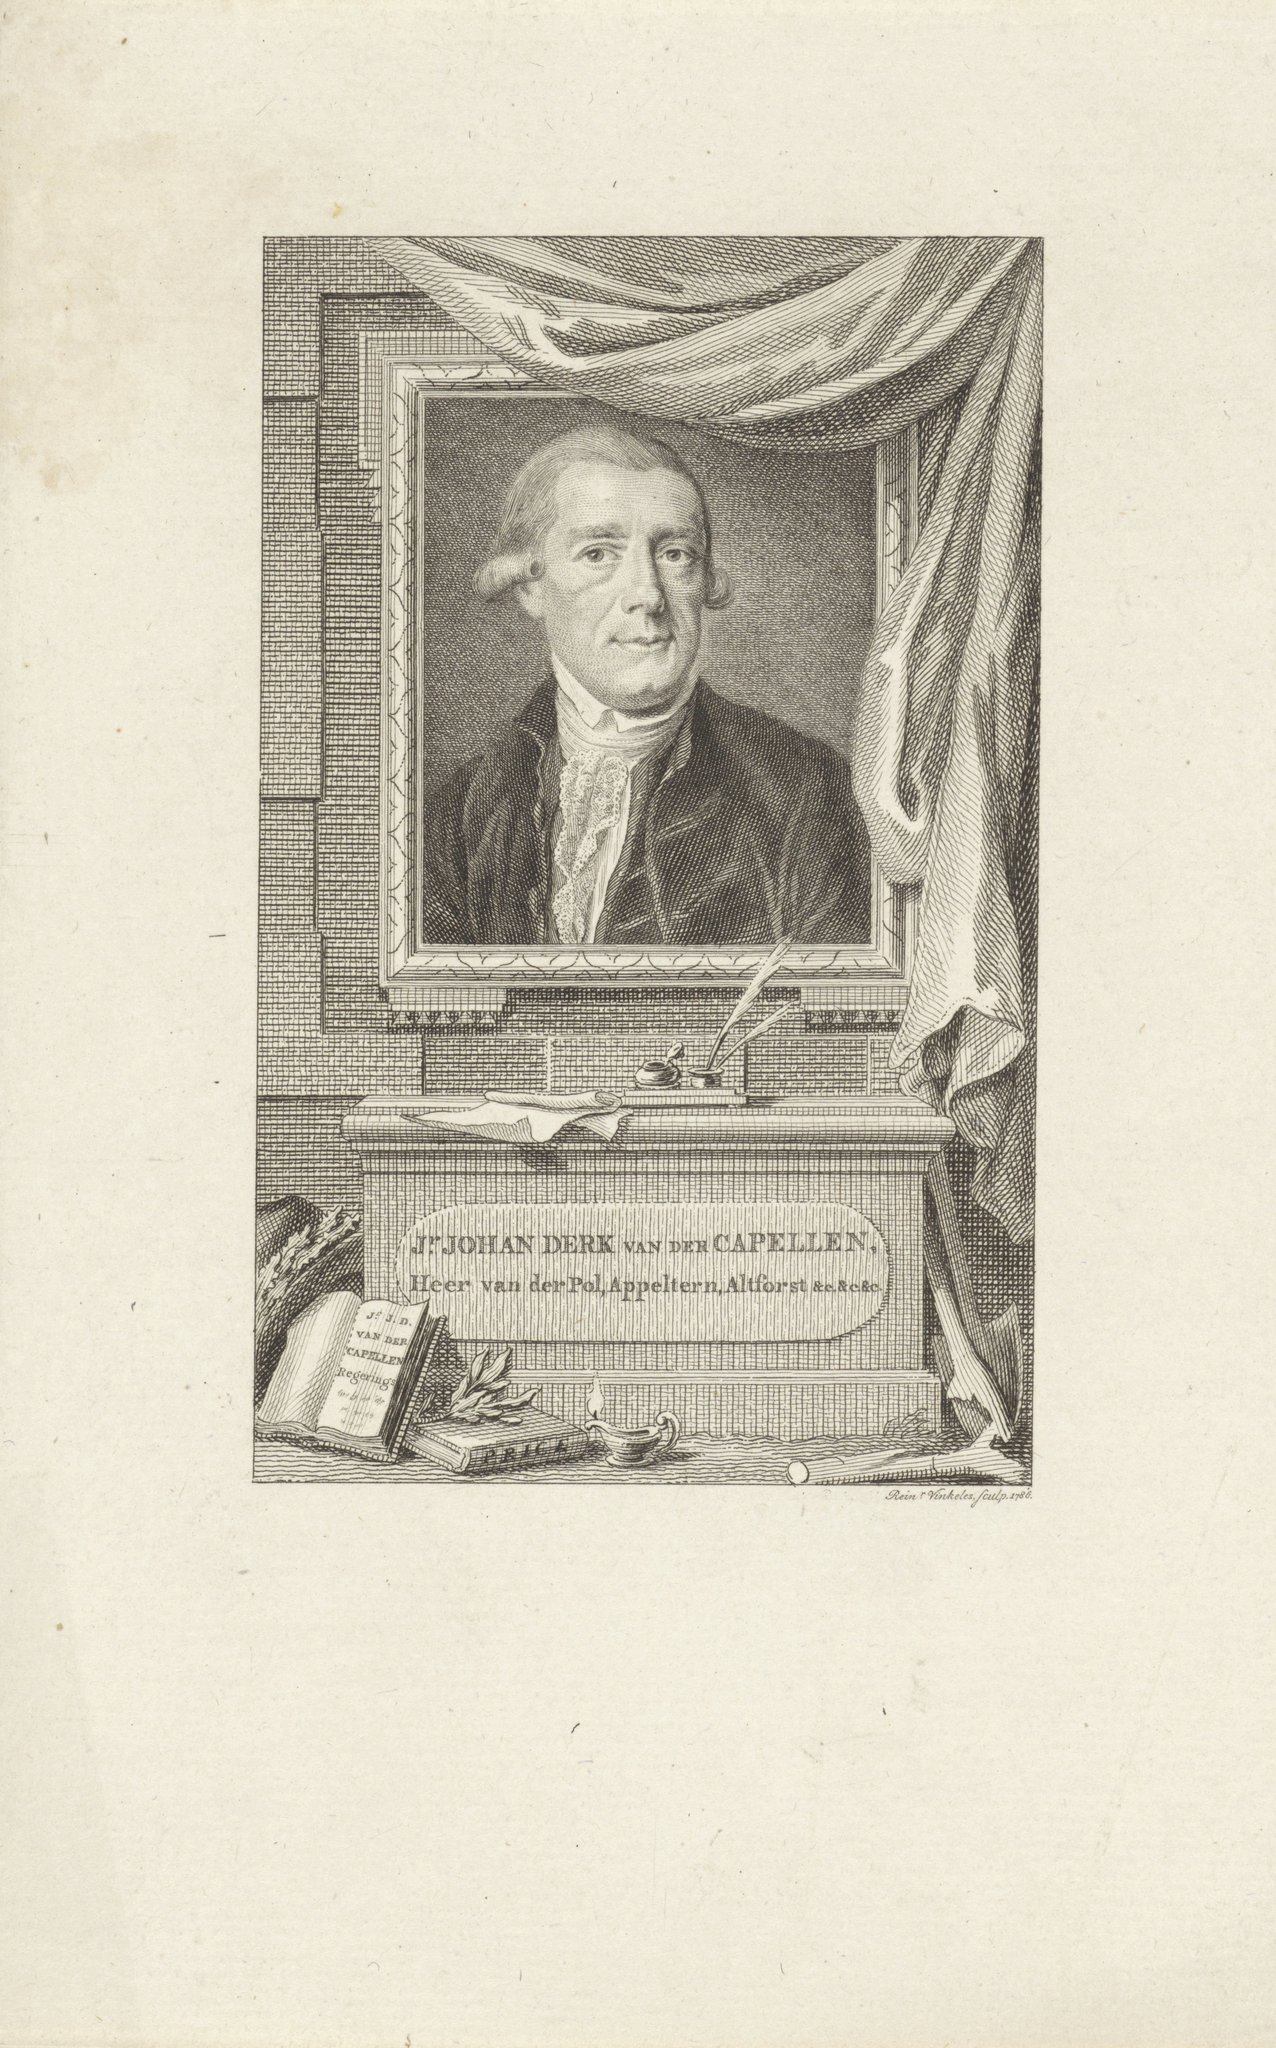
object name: print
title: Portret van Joan Derk van der Capellen tot den Pol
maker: reinier vinkeles (i)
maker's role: draughtsman, print maker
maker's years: 1741-1816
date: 1786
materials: paper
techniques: engraving, etching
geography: amsterdam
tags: politician, joan derk van der capellen tot den pol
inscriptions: collector's mark: Lugt 2228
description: Prent ook gebruikt als boekillustratie in: Wagenaar, Jan. Vaderlandsche historie, (...) ten vervolge van Wagenaars Vaderlandsche historie. Dl. 1-43. Amsterdam: Johannes Allart, 1786-1809.